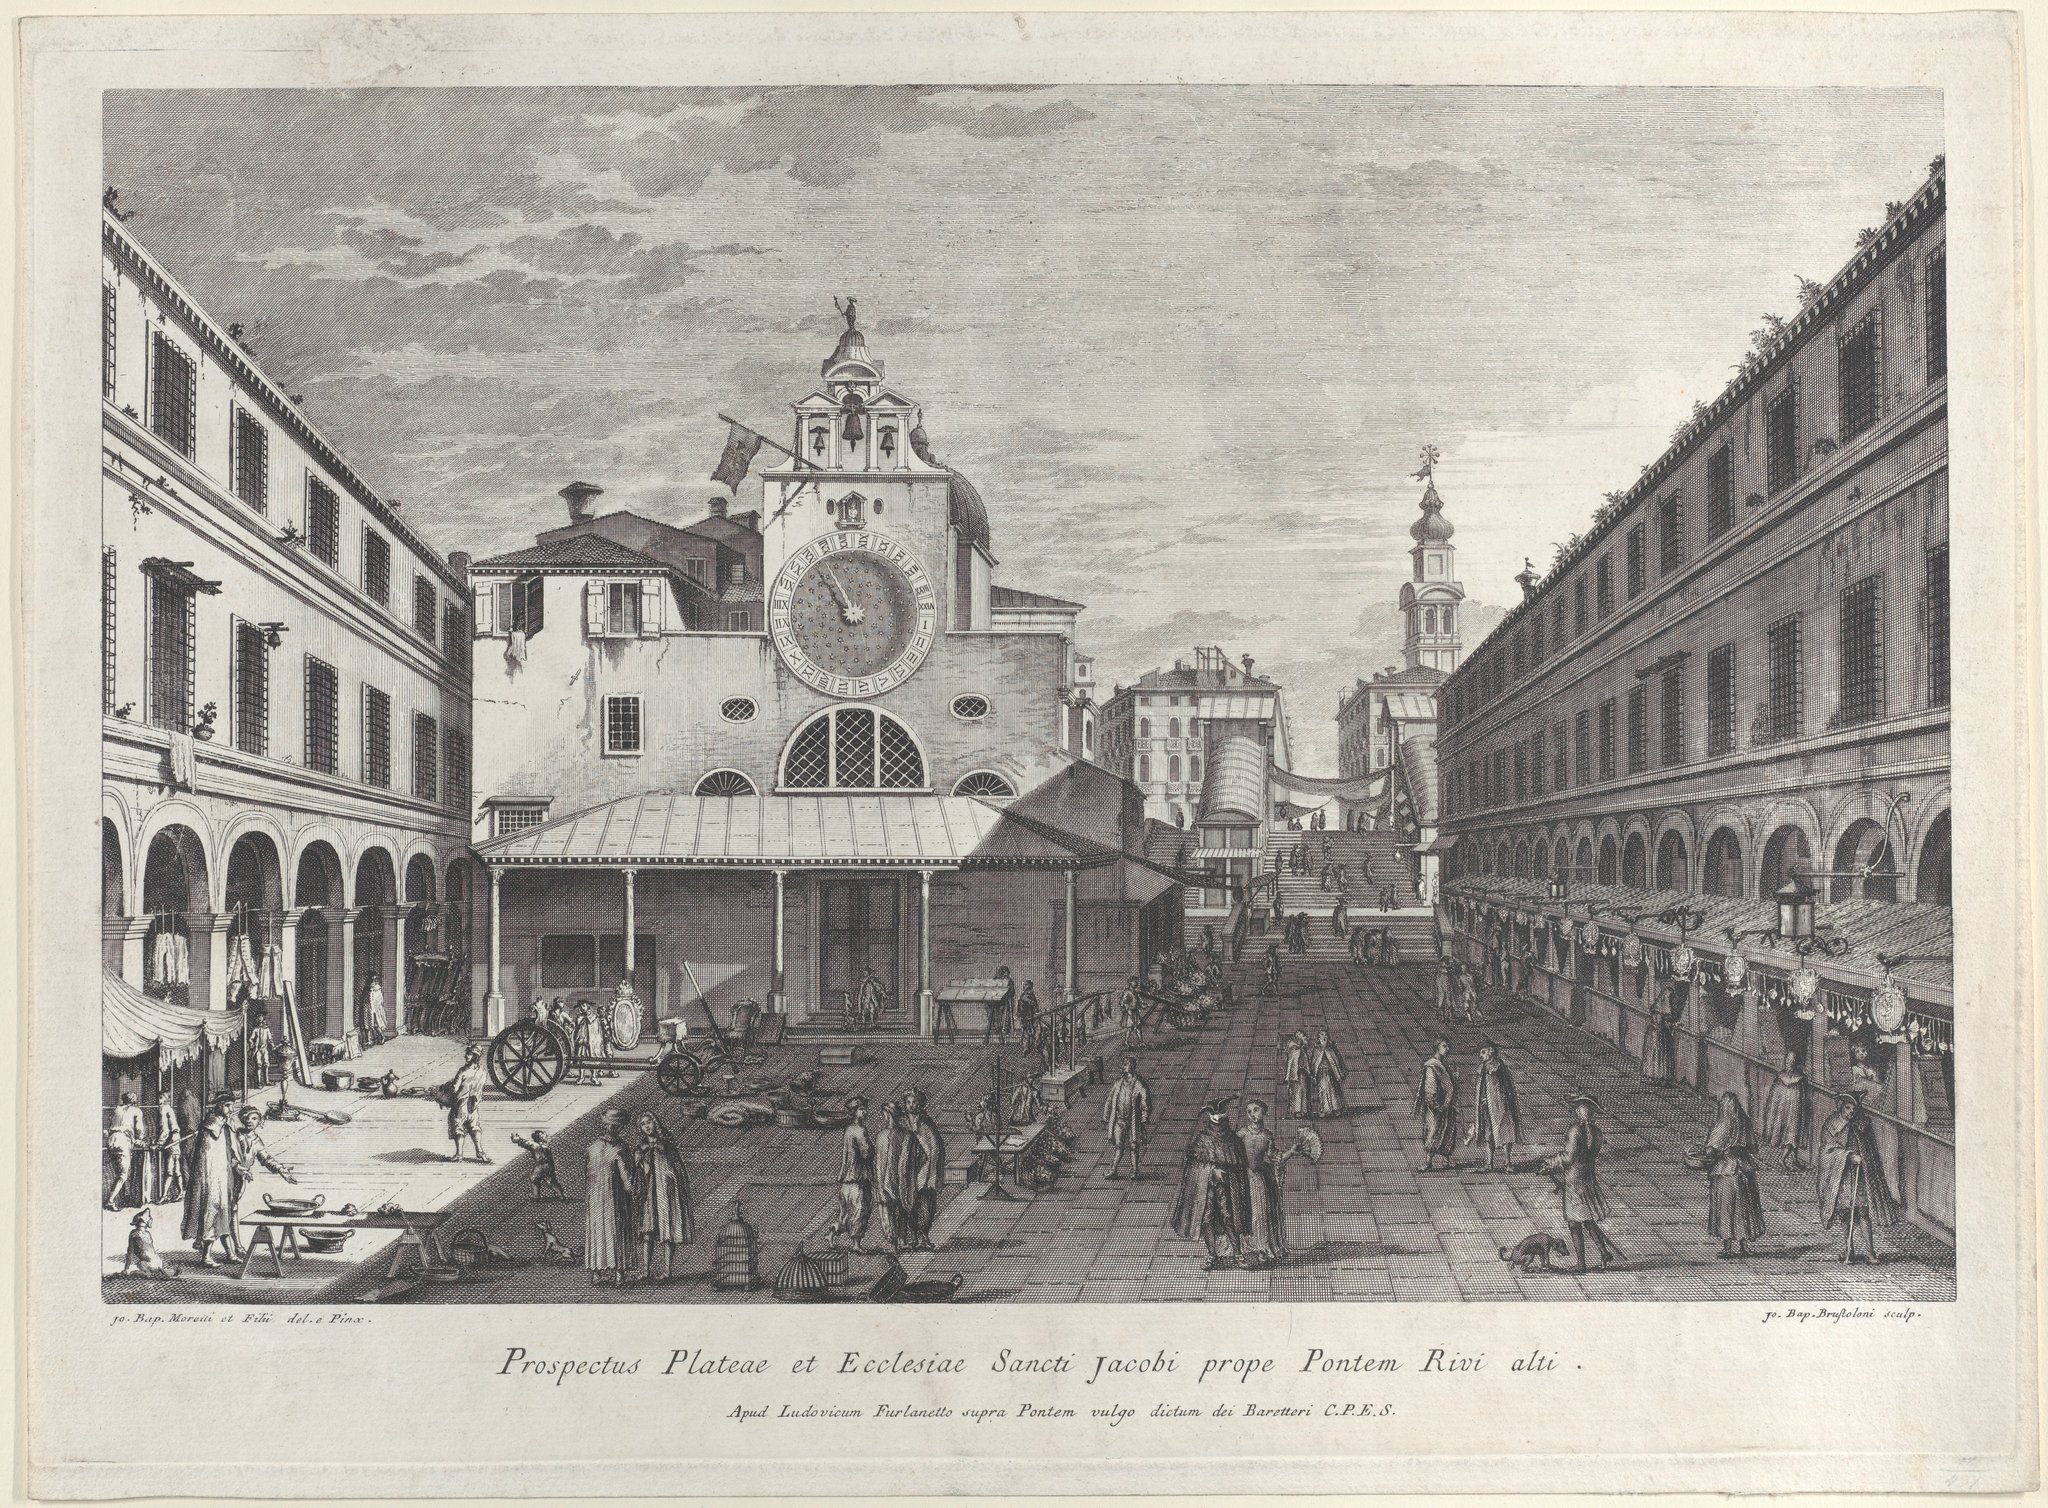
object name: print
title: The Church of San Giacomo di Rialto, at right Palazzo dei Dieci and the bridge of Rialto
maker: giovanni battista brustolon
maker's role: artist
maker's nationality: italian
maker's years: 1712-1796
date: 1763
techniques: etching